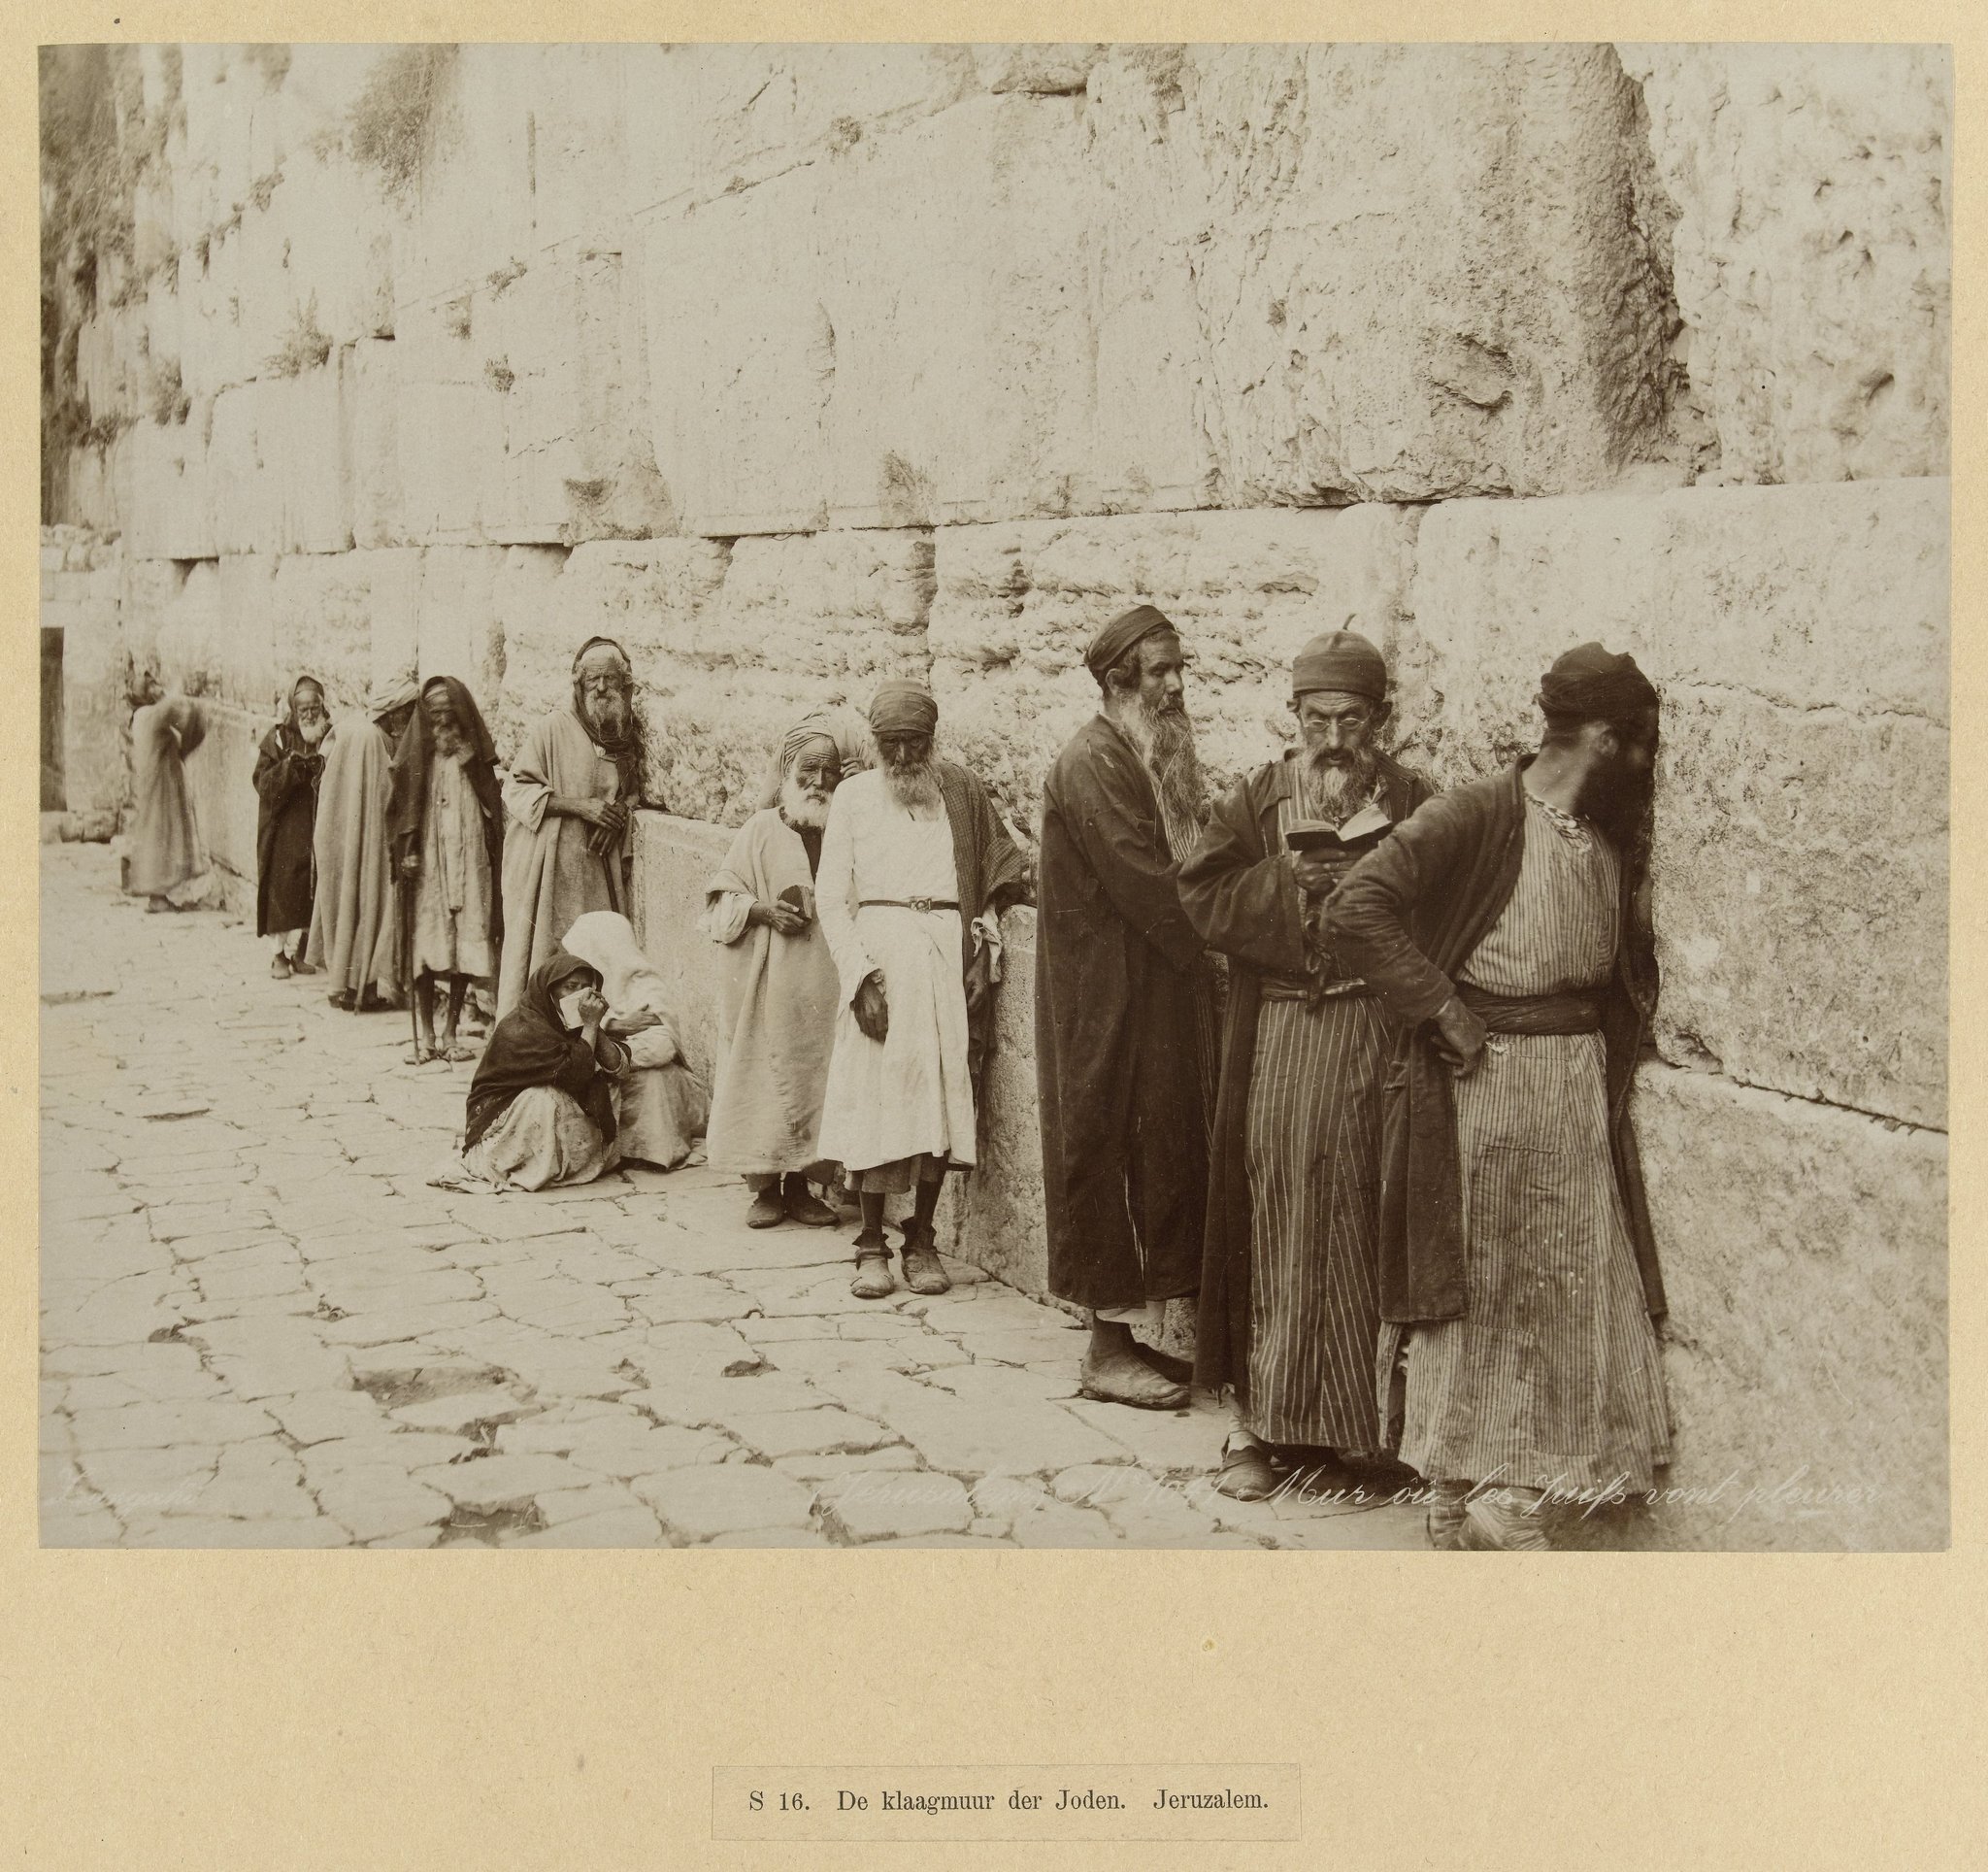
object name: photograph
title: S 16. De klaagmuur der Joden. Jeruzalem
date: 1870-1895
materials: cardboard, paper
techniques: albumen print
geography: jerusalem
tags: wailing wall ~ jewish religion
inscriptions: title: ‘S 16. De klaagmuur der Joden. Jeruzalem.’, number: ‘No 1041’, stamp: ‘Gemeentelijke bibliotheek/ Rotterdam’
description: Onderdeel van een groep door fotograaf Richard Polak op reis verzamelde foto’s. Deze foto is samen met andere op zijn reizen verzamelde foto's tentoongesteld bij de Rotterdamsche Kunstkring (1895), Arti en Amicitiae te Amsterdam (1897-1898?) en Societeit 't Collegie te Kampen (datum vooralsnog onbekend).